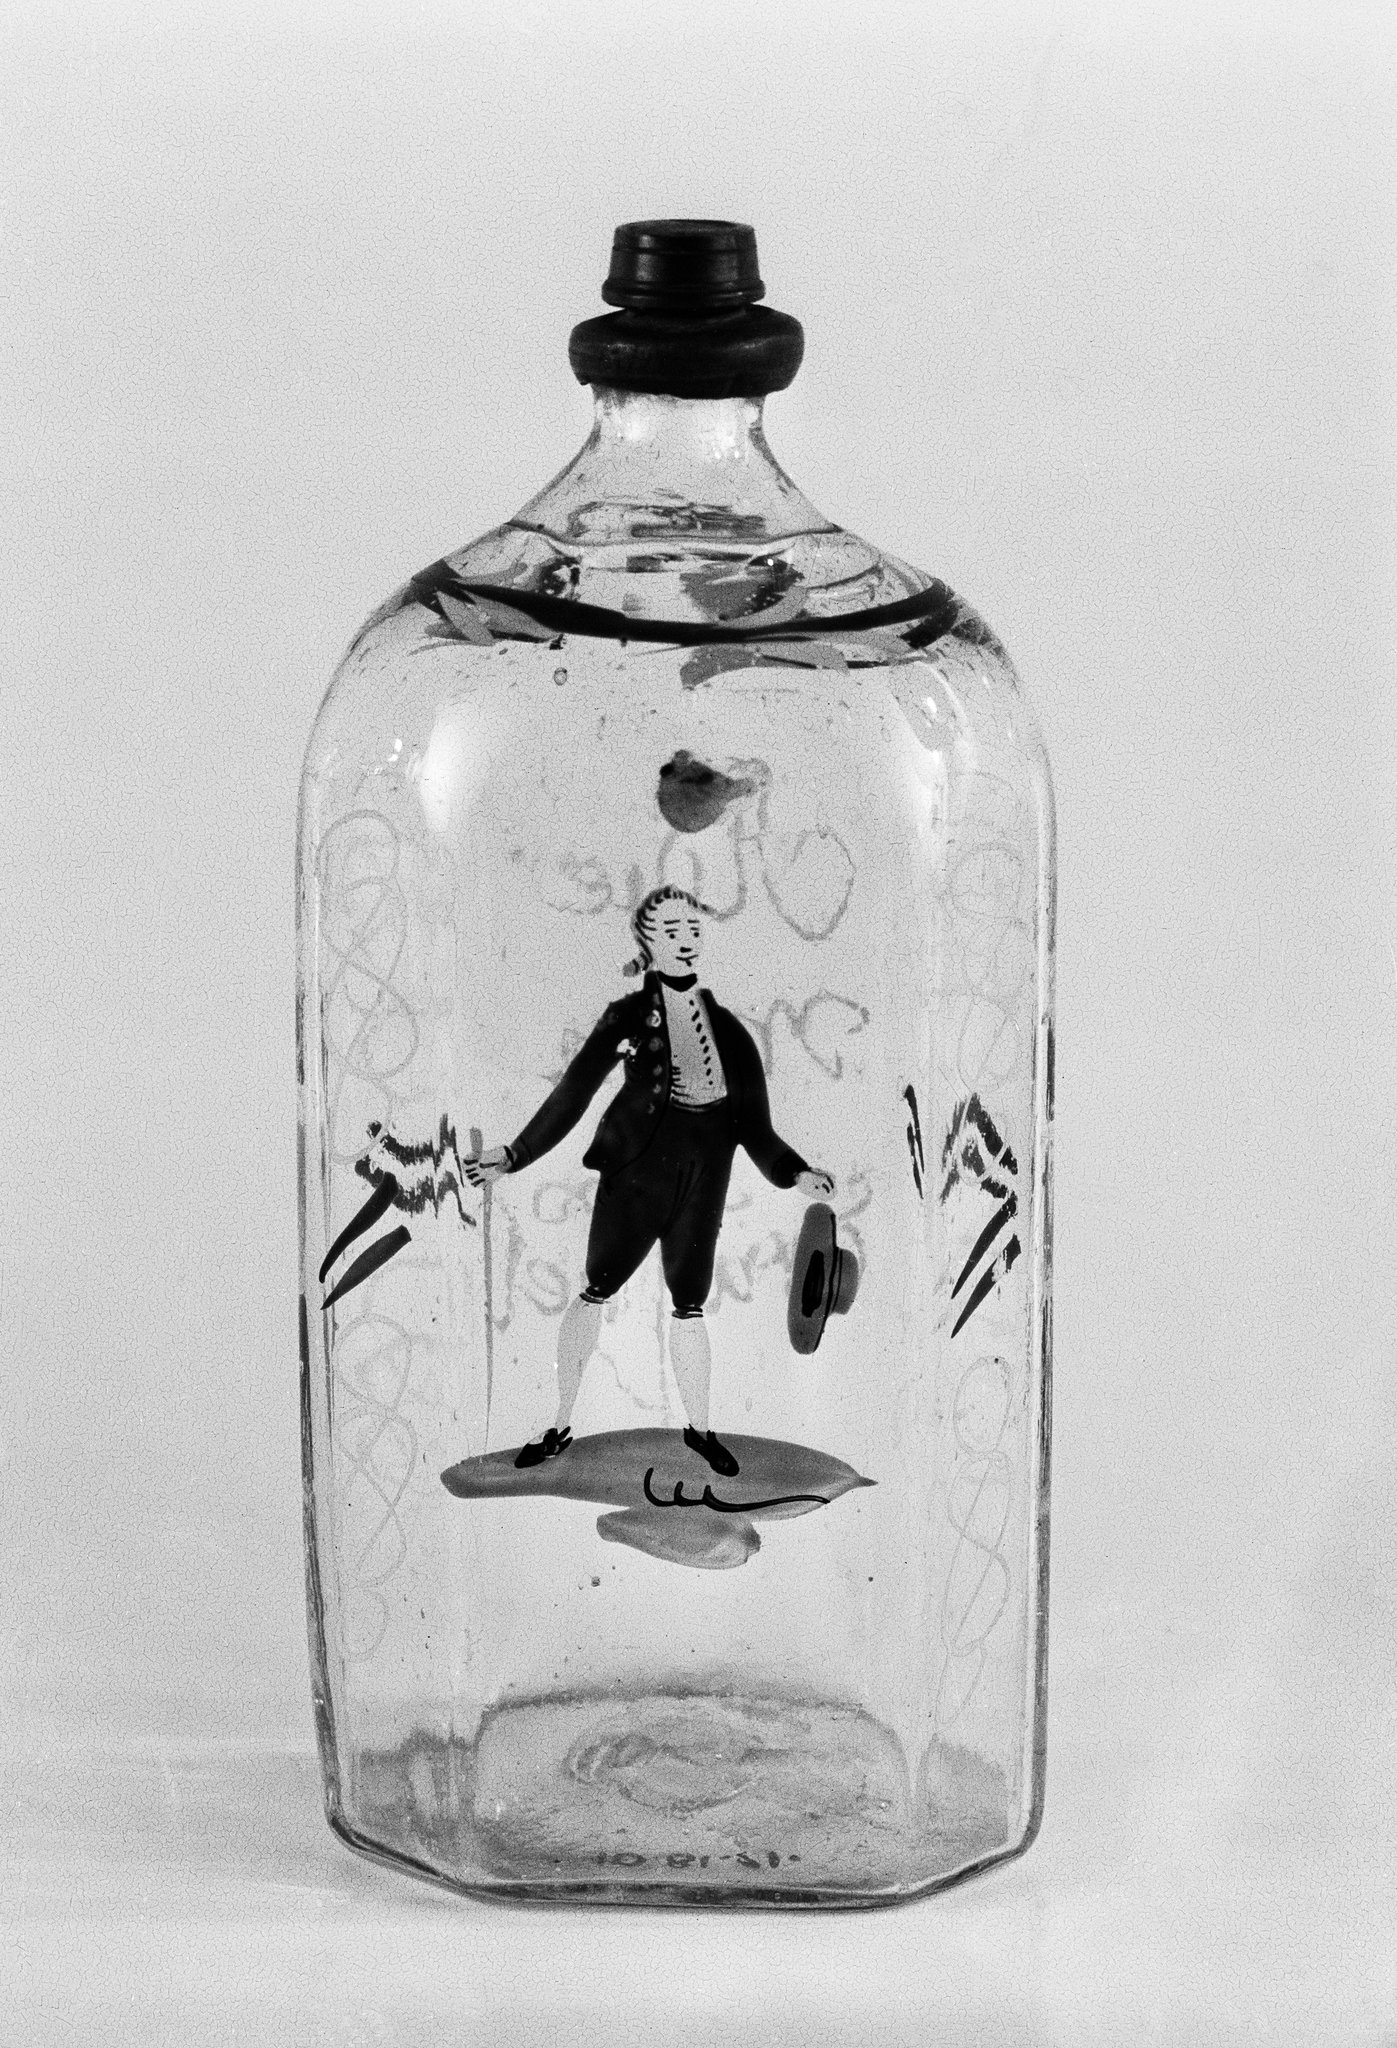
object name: bottle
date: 1701-1800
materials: glass, pewter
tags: men